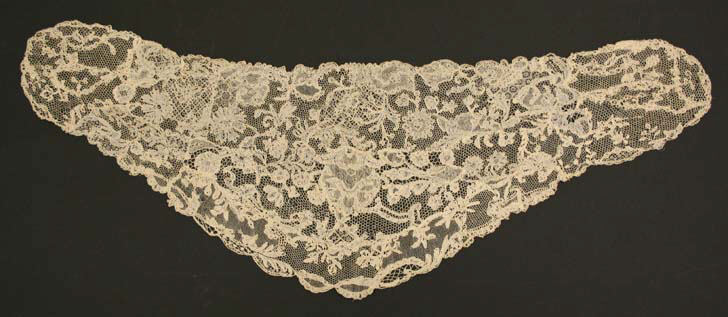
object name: collar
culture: french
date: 1701-1733